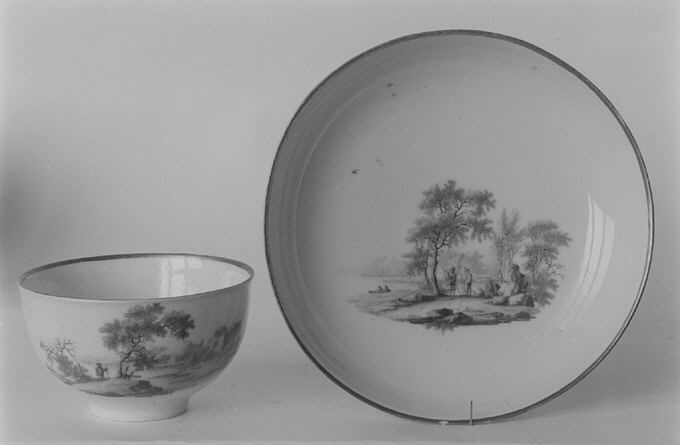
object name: teabowl and saucer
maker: zurich pottery and porcelain factory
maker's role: factory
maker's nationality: swiss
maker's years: 1763-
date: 1770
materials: hard paste porcelain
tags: human figures,trees